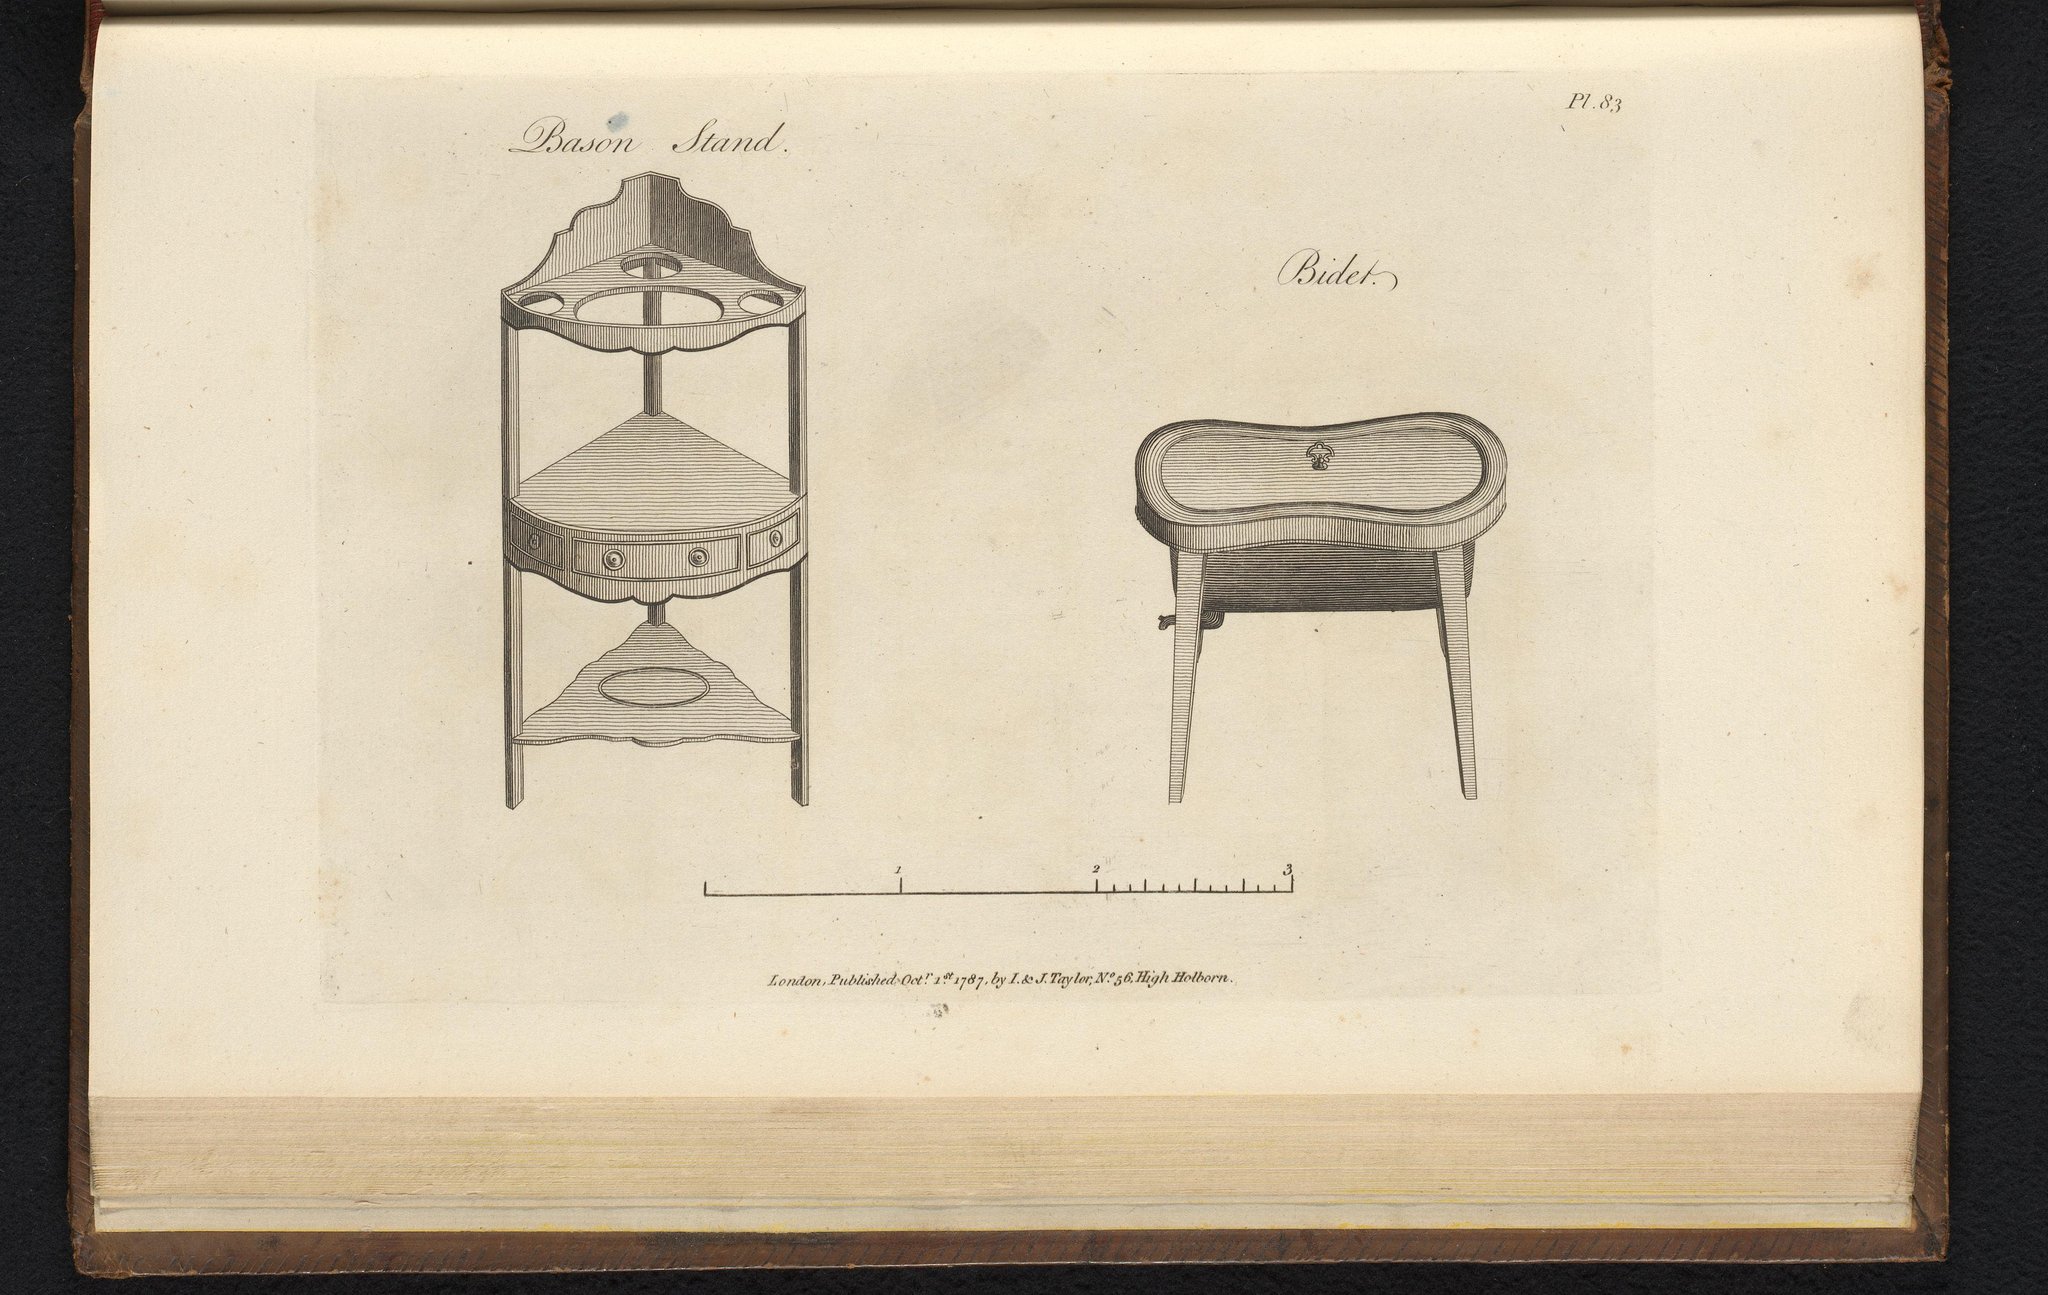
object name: page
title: Meubels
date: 1787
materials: paper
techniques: engraving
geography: holborn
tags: bidet, furniture and household effects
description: Genummerd: Pl. 83. Schaalverdeling in de ondermarge. Prent maakt deel uit van een boek.